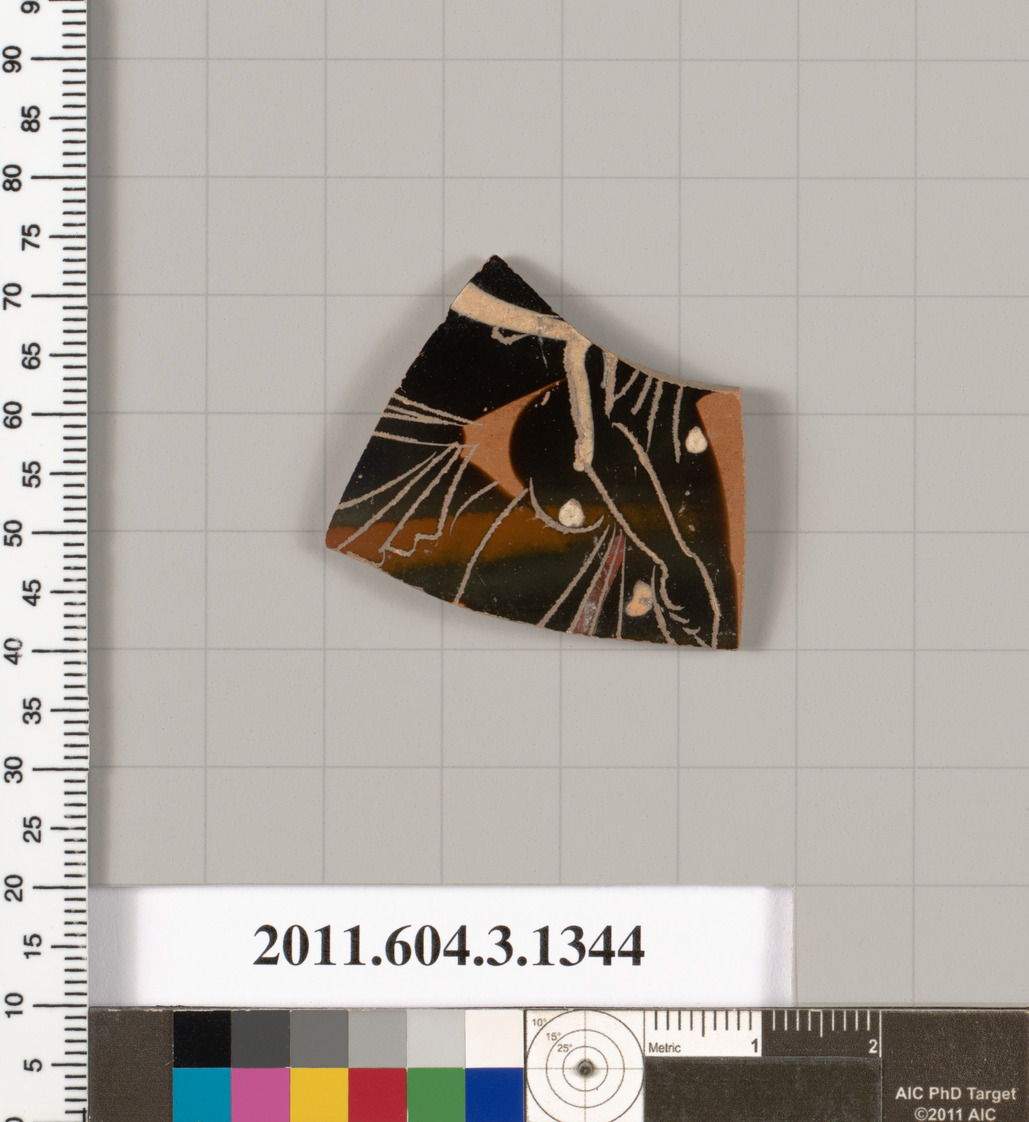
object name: skyphos fragment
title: Terracotta fragment of a skyphos (deep drinking cup)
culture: greek, attic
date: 500-468 BCE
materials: terracotta